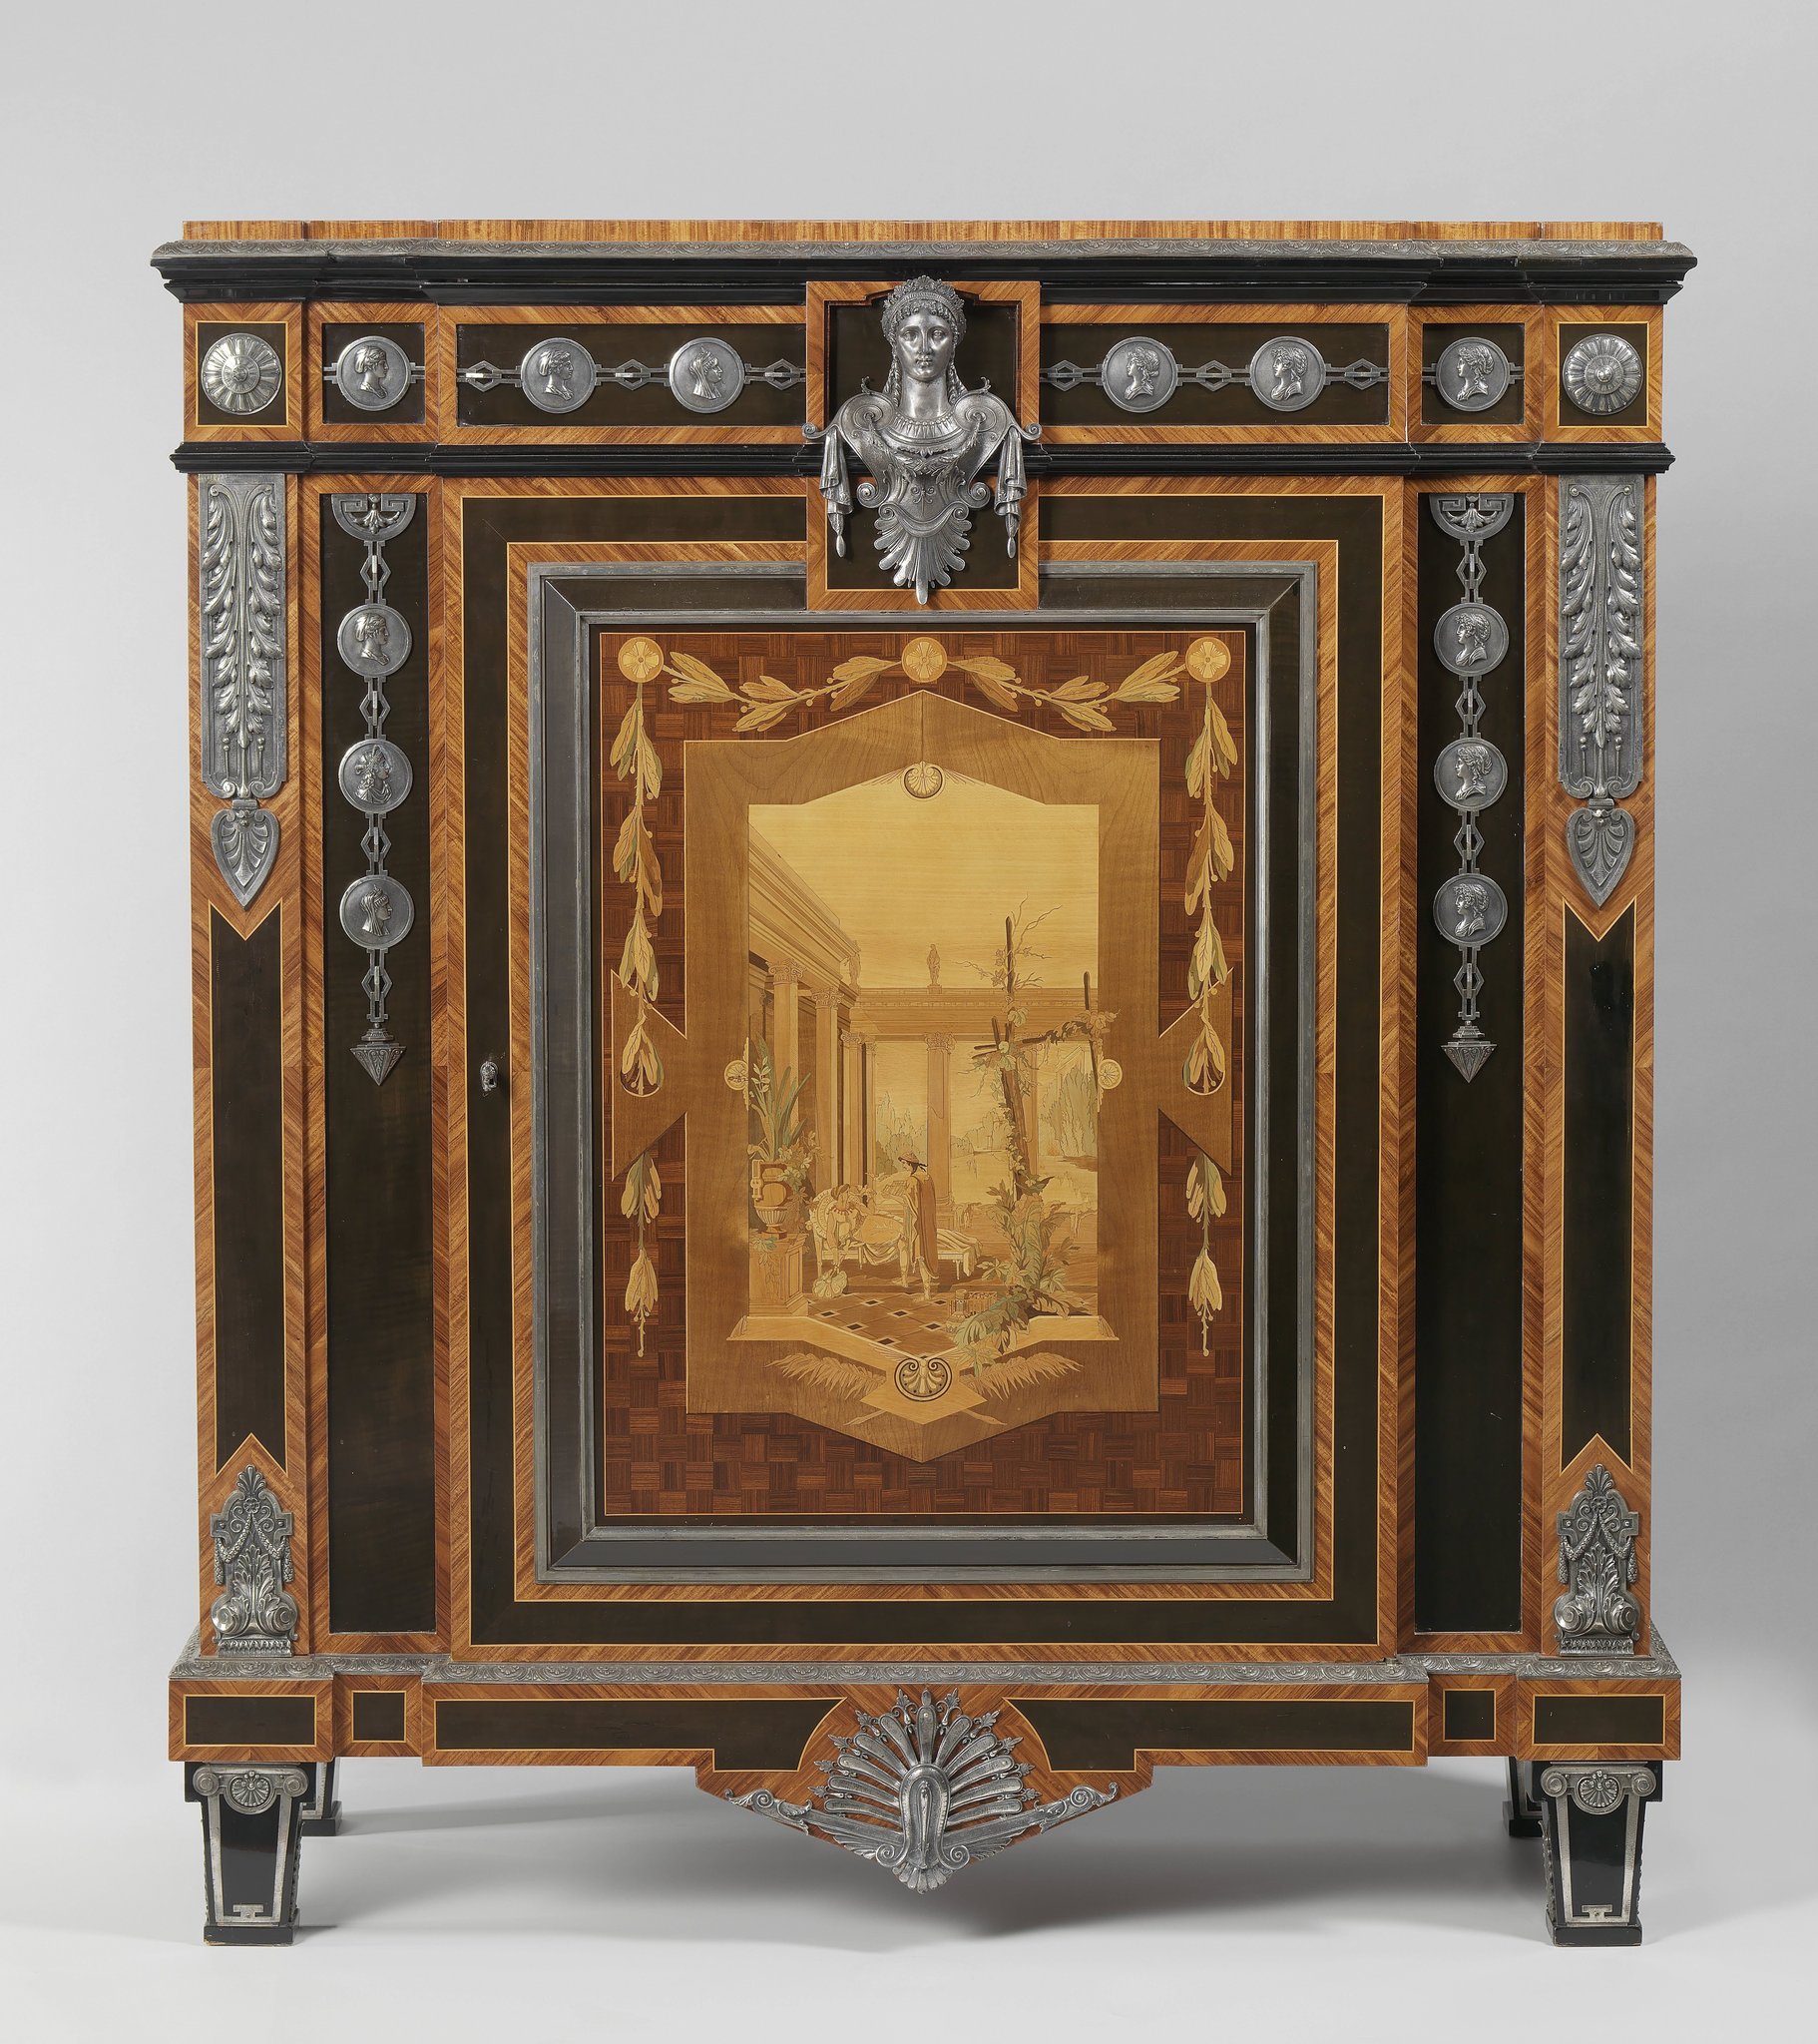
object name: case furniture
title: Cabinet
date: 1867-1880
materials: wood, bronze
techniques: inlay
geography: paris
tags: couch, sofa, settee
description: At the 1867 Exposition Universelle in Paris the cabinetmaker Charles Diehl caused a great stir with a jewellery cabinet in a Greek Revival style. This is a somewhat plainer version of that cabinet. All the motifs of the inlaid work on the door refer to Greek antiquity, as do the silvered bronze fittings, which imitate Classical figures and coins.